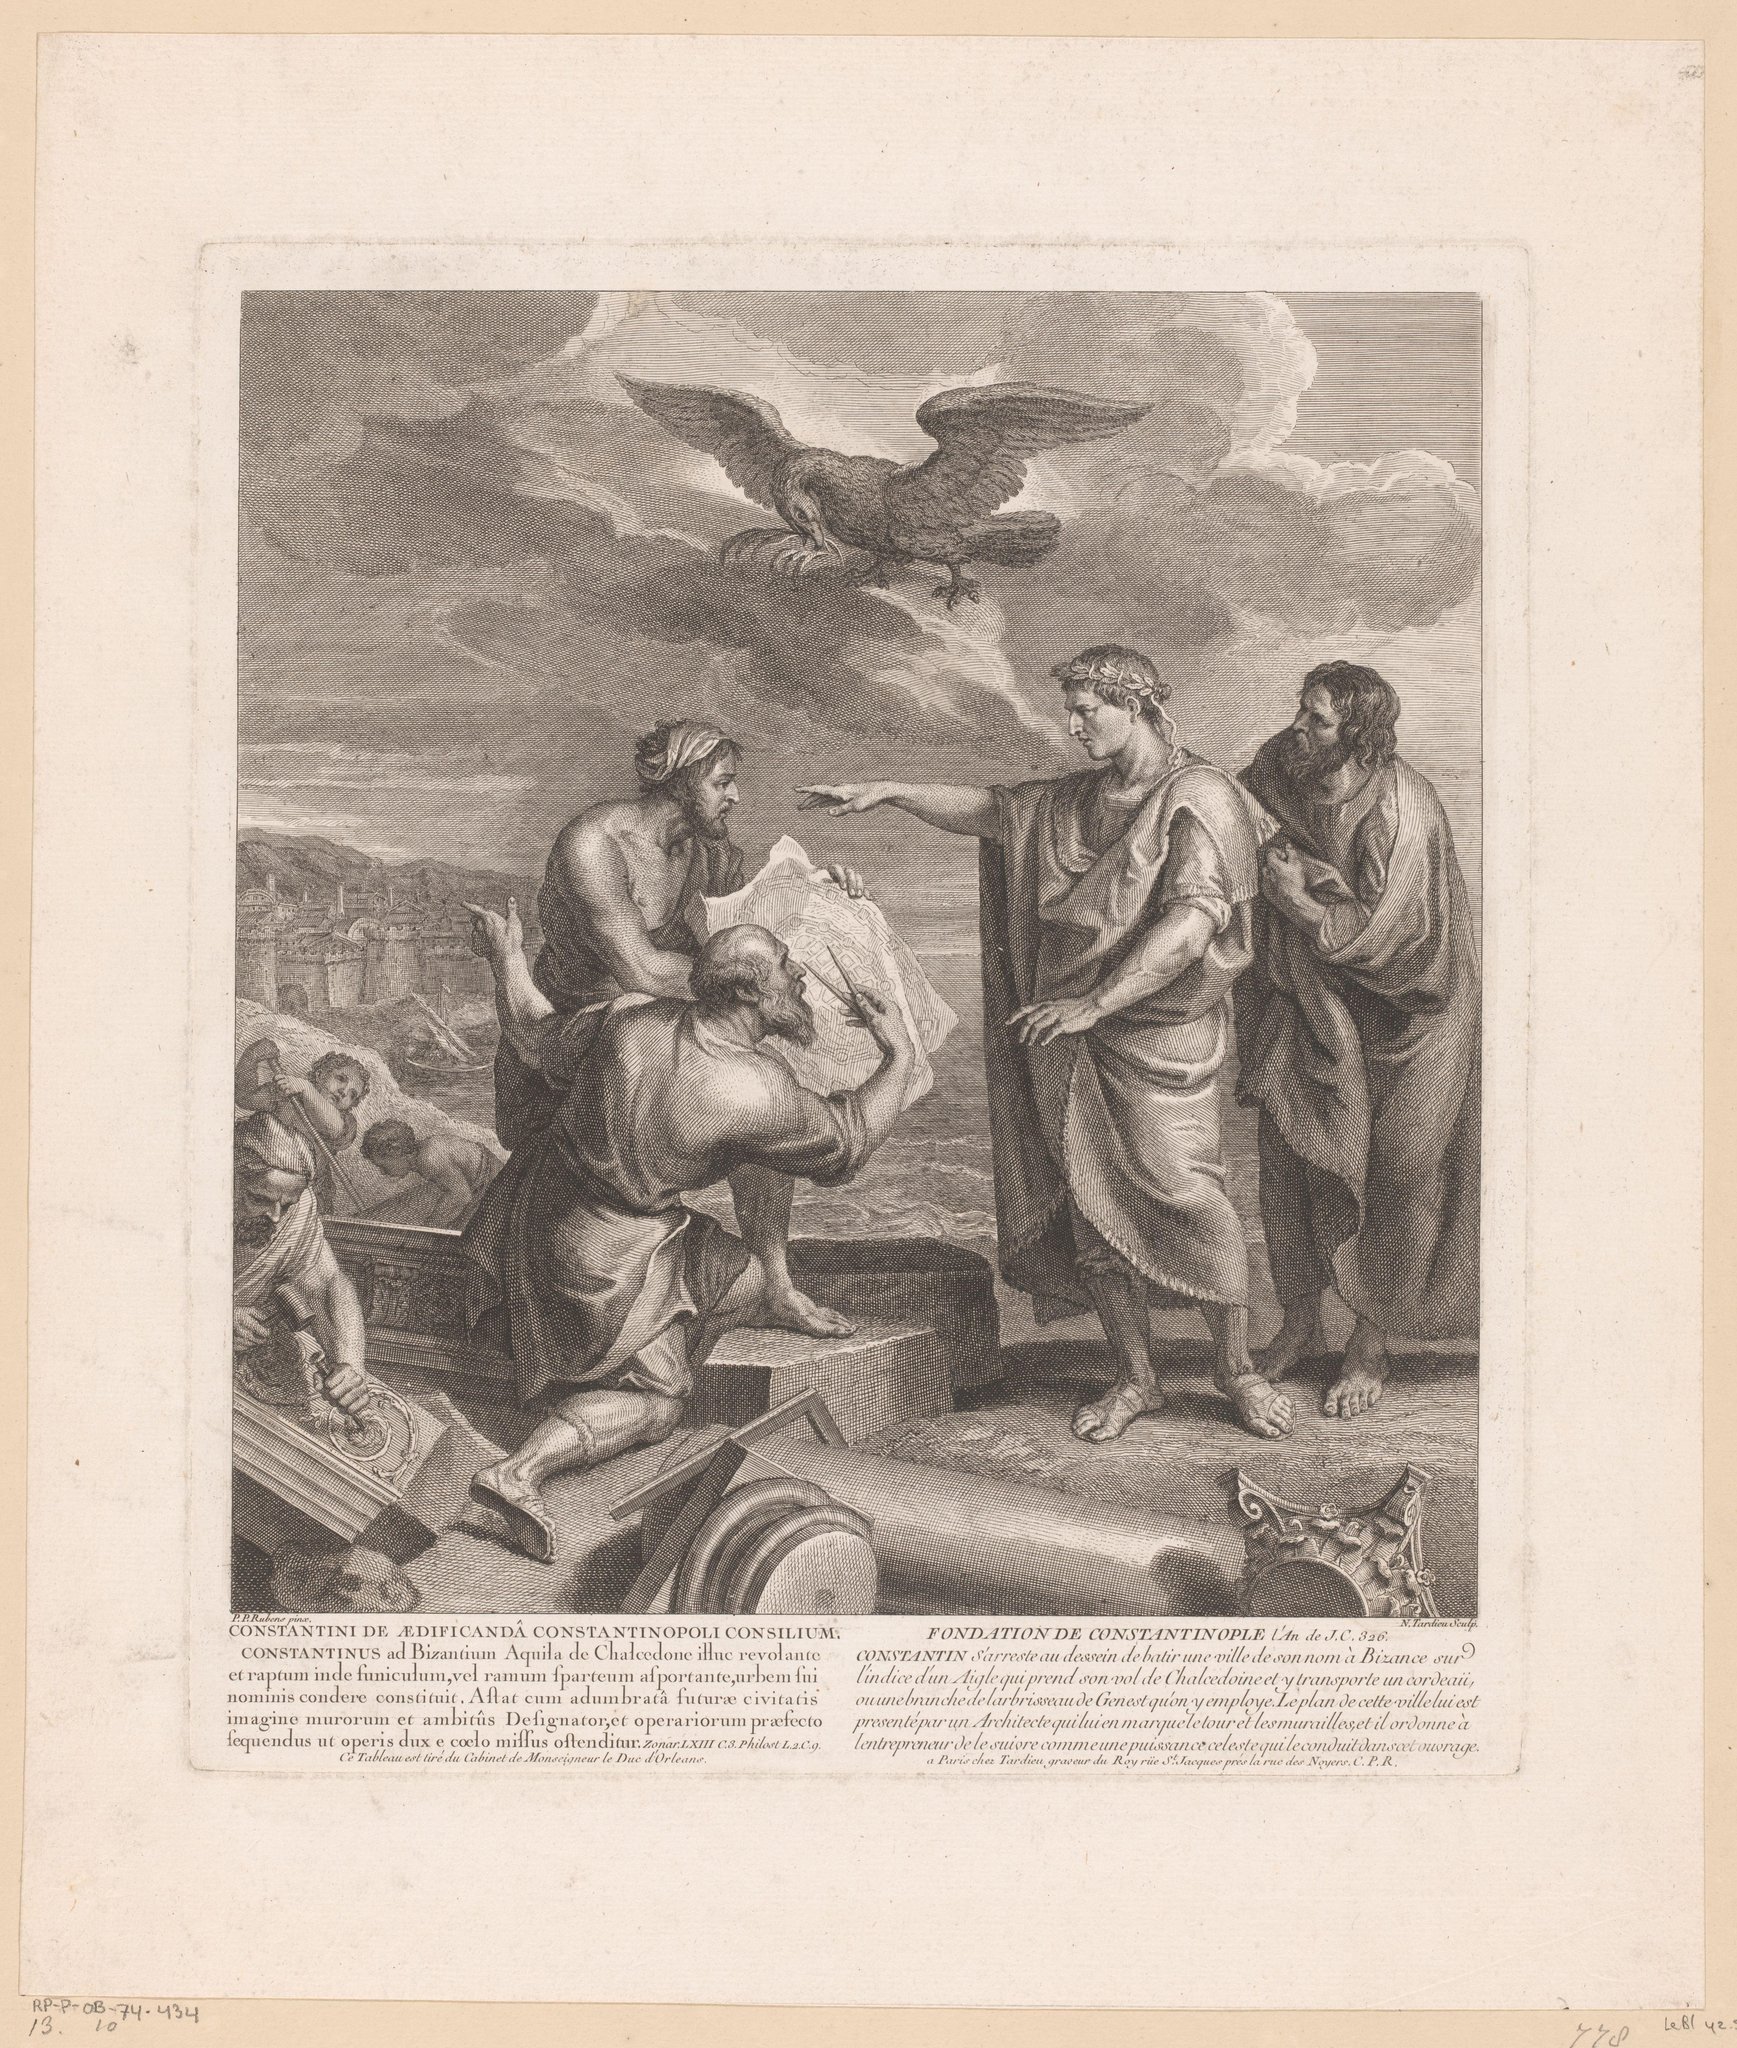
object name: print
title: Geschiedenis van keizer Constantijn de Grote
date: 1684-1749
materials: paper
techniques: engraving, etching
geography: paris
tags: city founding, the roman emperor constantine the great; possible attributes: crown, sceptre, standard (labarum) with chi-rho monogram or cross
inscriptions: collector's mark: Lugt 240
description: Een architect toont keizer Constantijn de Grote een plattegrond voor de stad Constantinopel. Boven hen in de wolken een adelaar.